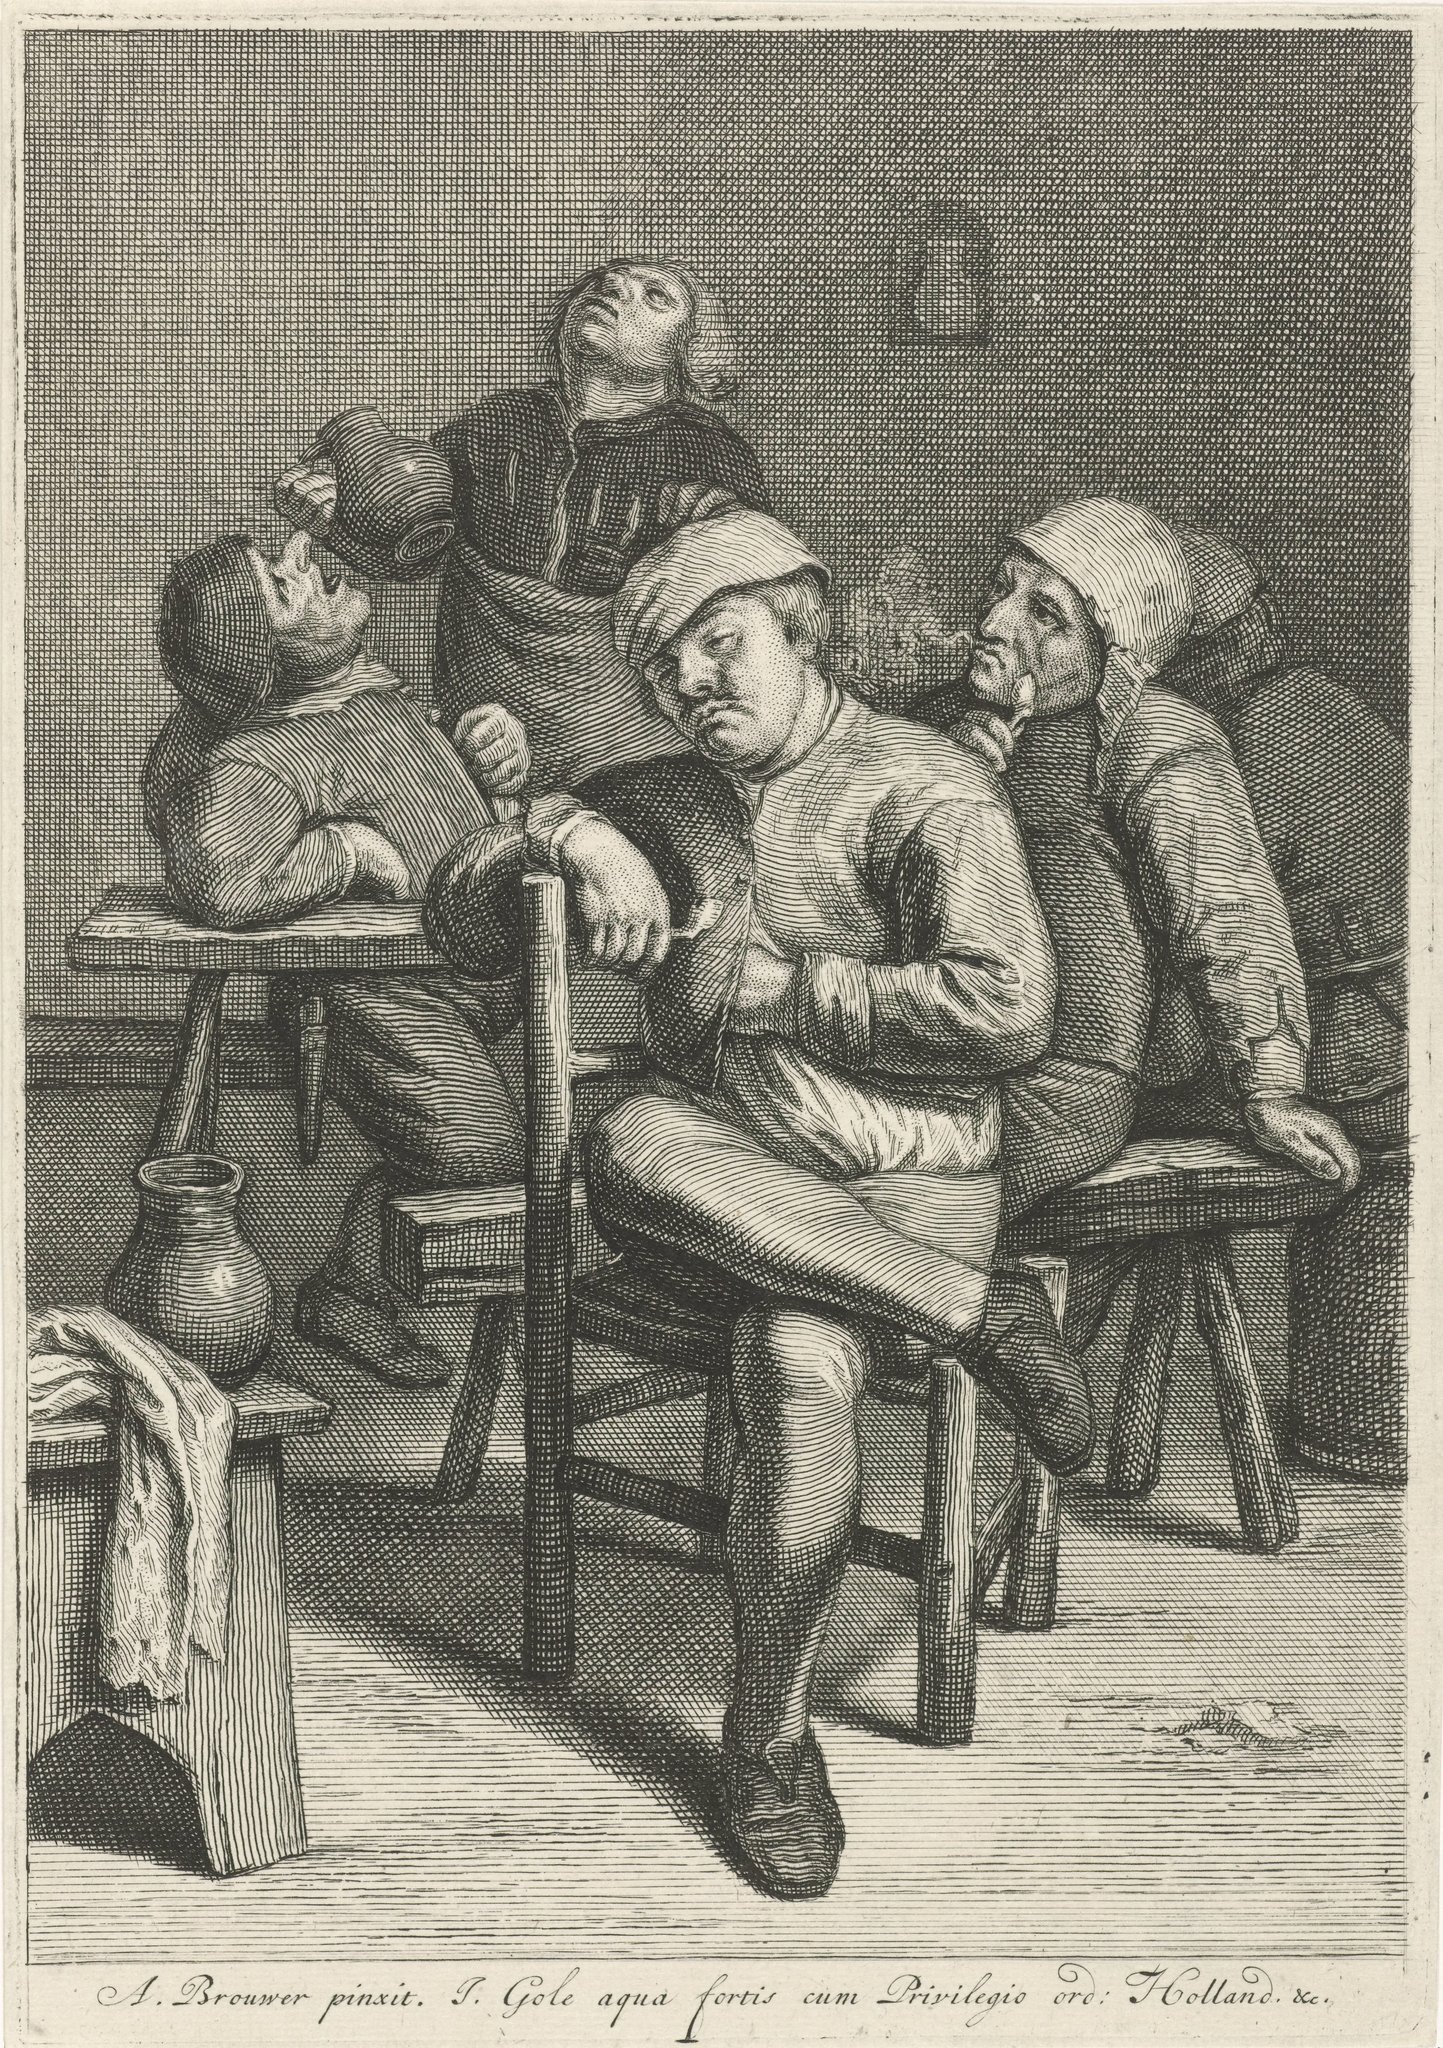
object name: print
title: Herbergscène met rokende boeren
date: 1670-1724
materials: paper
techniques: etching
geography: amsterdam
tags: inn, coffee-house, public house, etc., pipe ~ tobacco, farmers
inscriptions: collector's mark: Lugt 2228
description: In het midden van een herberg zit een boer met een pijp in de hand. Achter hem drie zittende boeren aan een tafel en de herbergier, met een kan in de rechterhand.